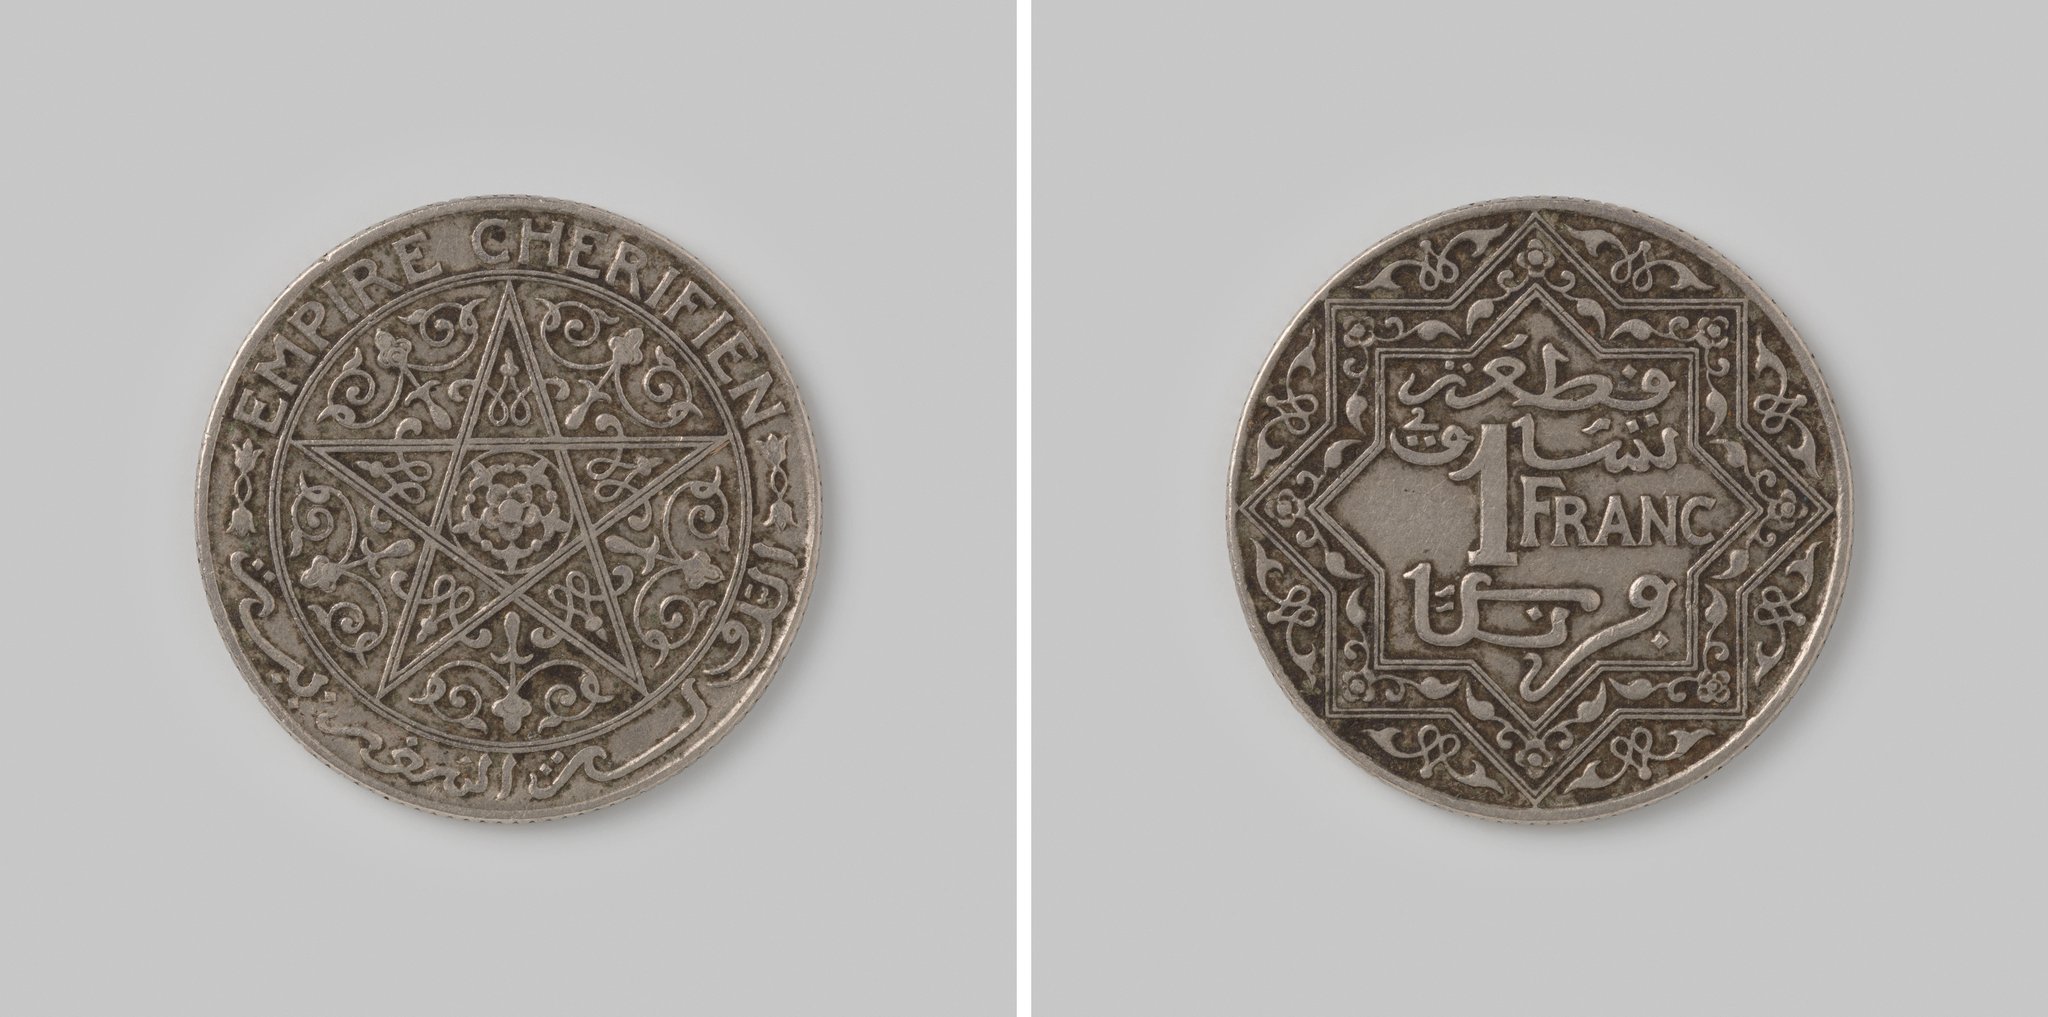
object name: coin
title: Franse protectoraat Marokko, Empire Cherifien, franc, 1921-1924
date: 1921-1924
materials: nickel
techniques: striking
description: Nikkelen munt. Voorzijde: vijfpuntige ster, waarin en waaromheen versiering. Keerzijde: binnen een uit twee rechthoeken bestaande achthoek waarde-aanduiding: 1 franc. Kartelrand.